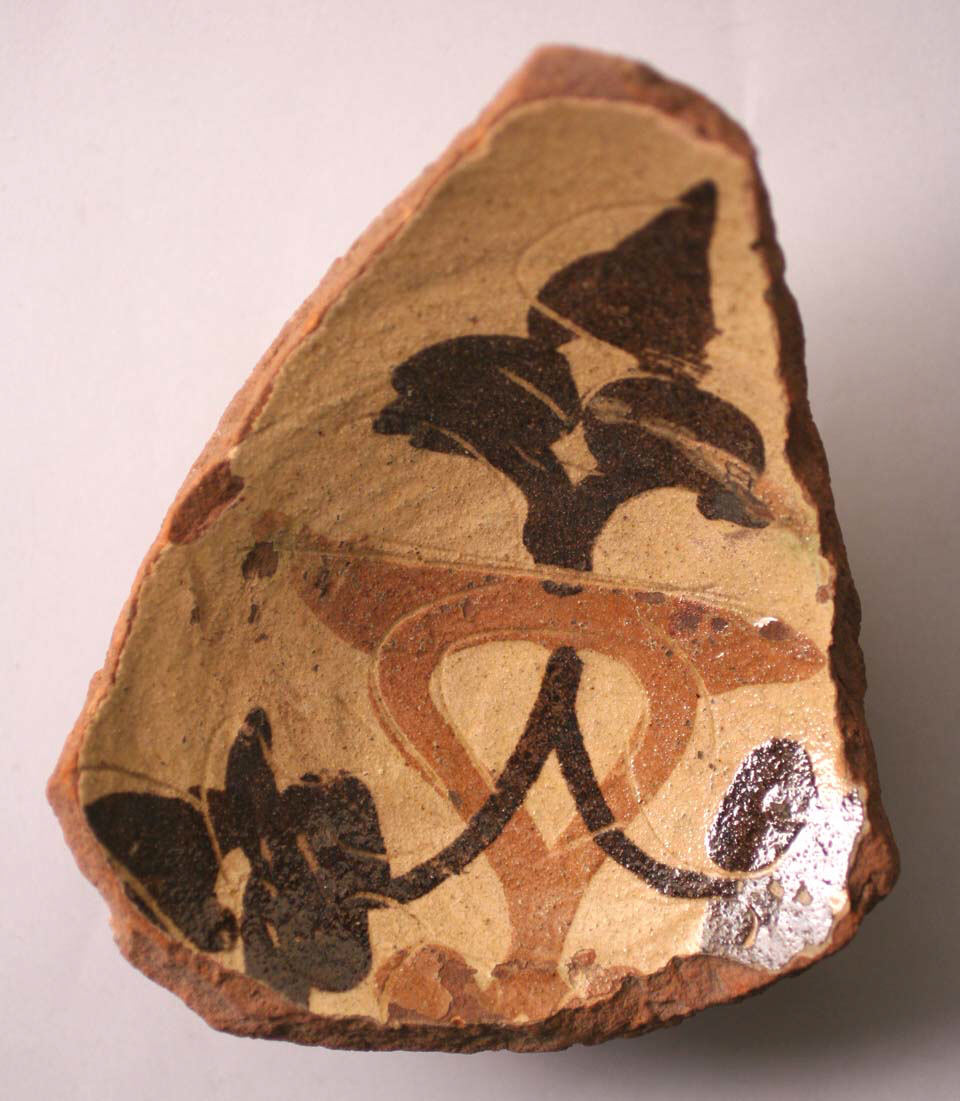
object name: ceramic fragment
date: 1301-1500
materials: earthenware, glaze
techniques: incising, painting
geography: egypt